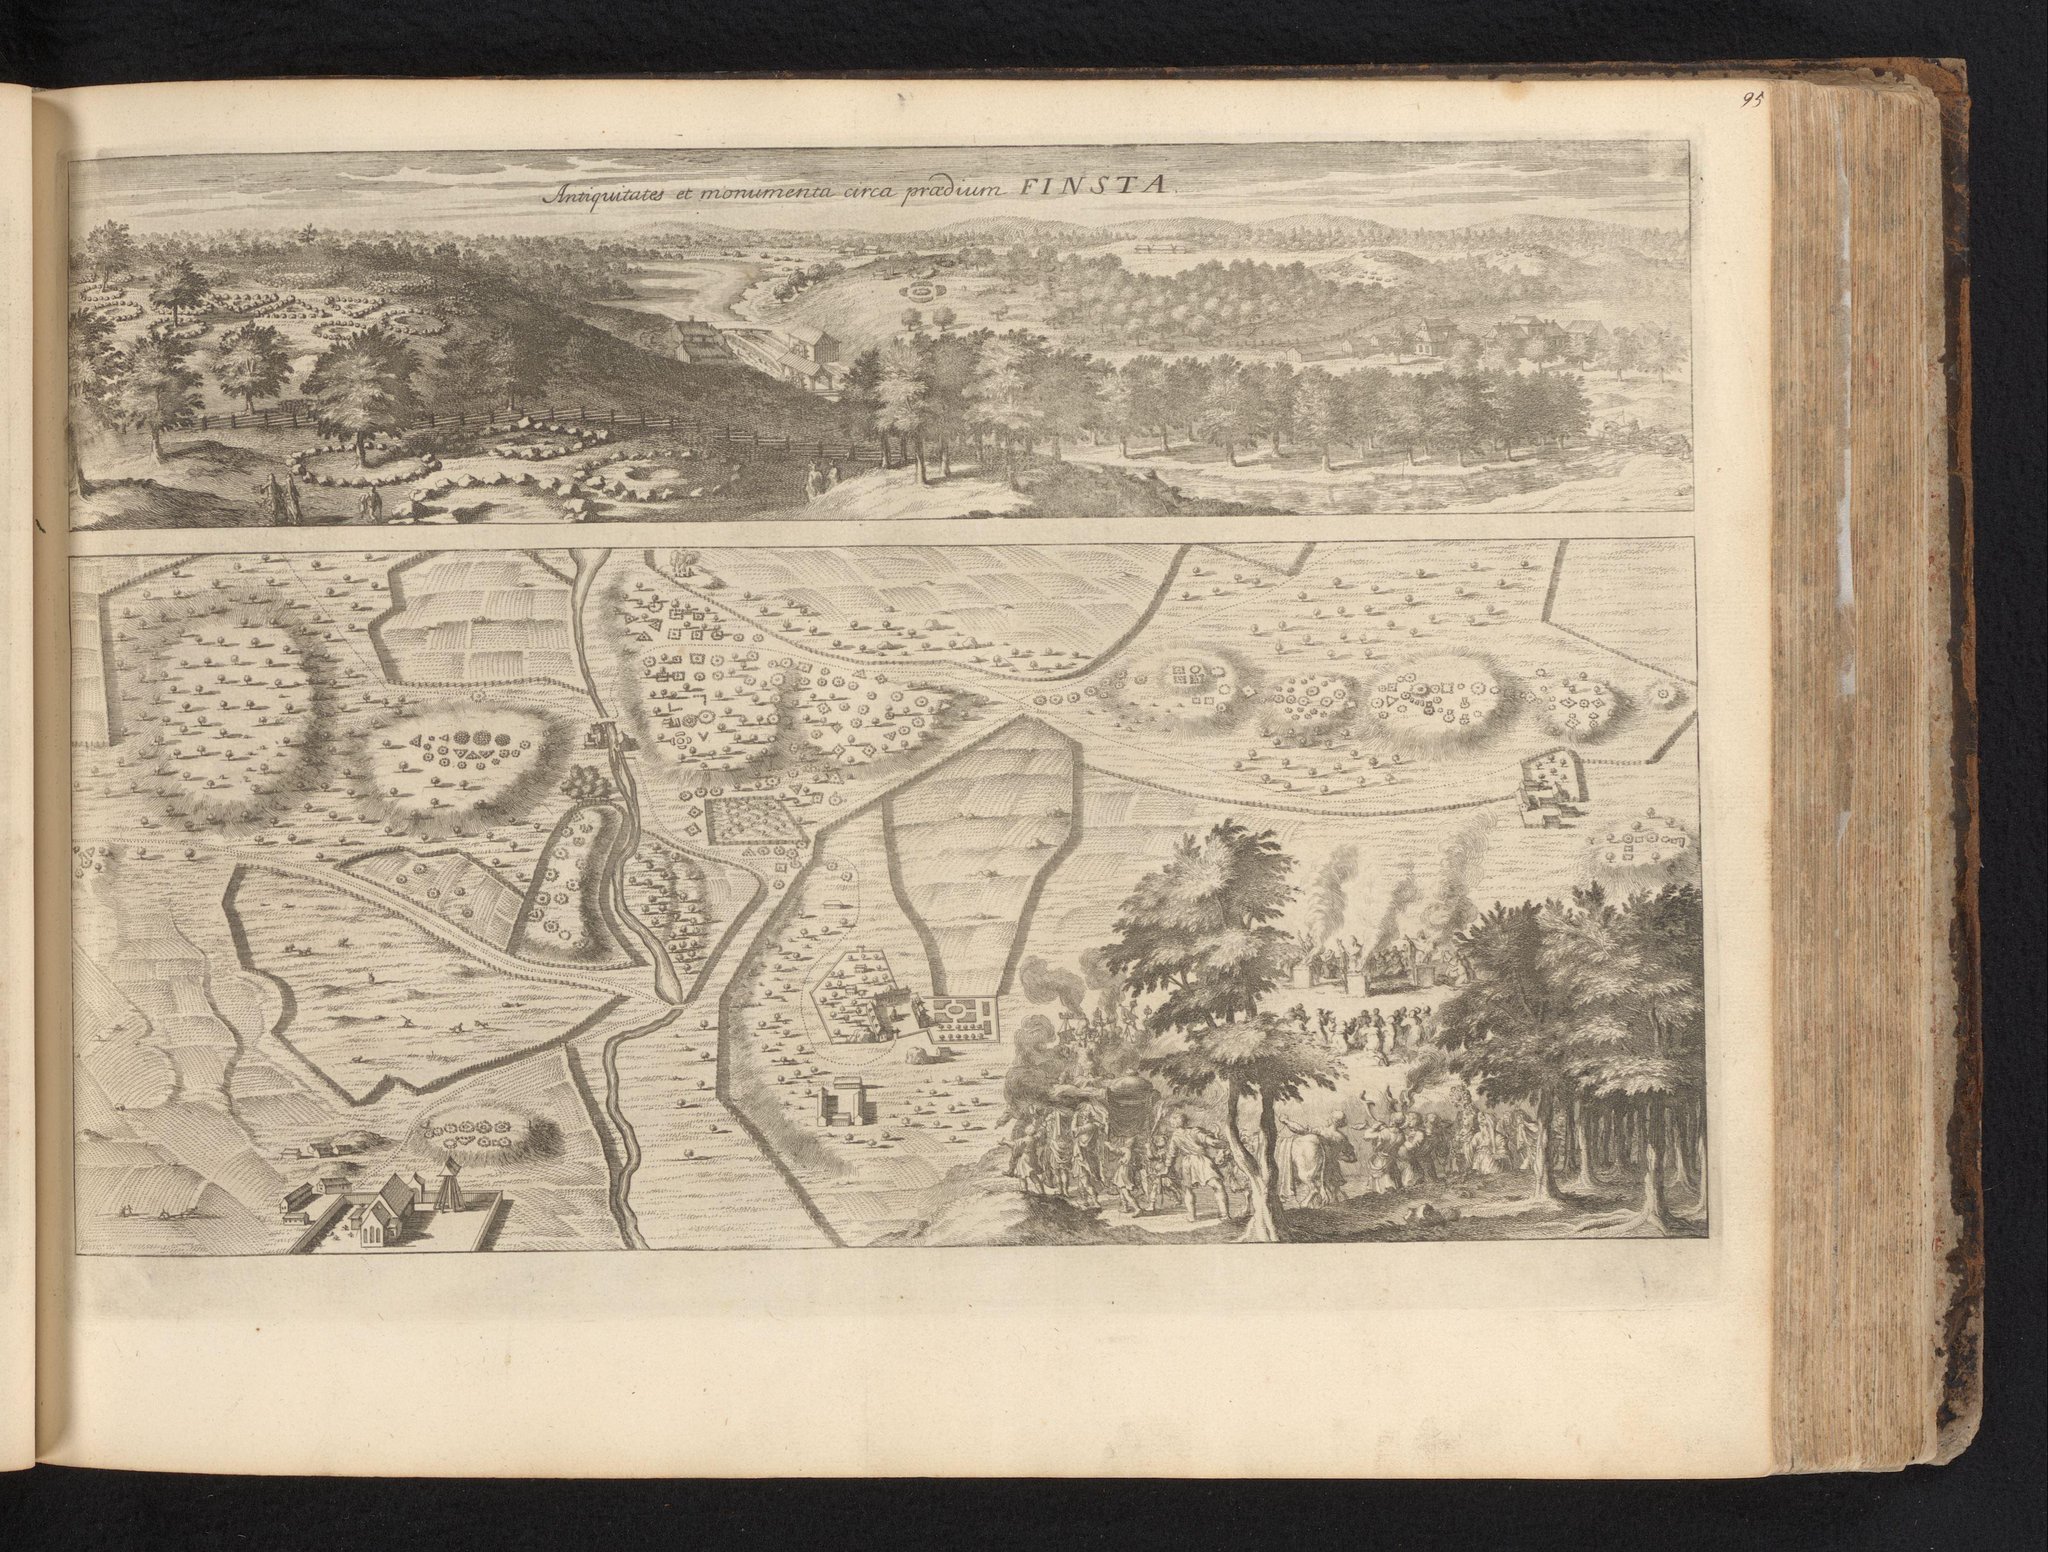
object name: album leaf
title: Antiquitates et monumenta circa praedium Finsta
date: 1708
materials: paper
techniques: etching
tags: landscape with monument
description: Kungliga Biblioteket, 'Suecia': http://www.kb.se/samlingarna/Kartor-bilder/Suecia-antiqua/ (geraadpleegd november 2016).